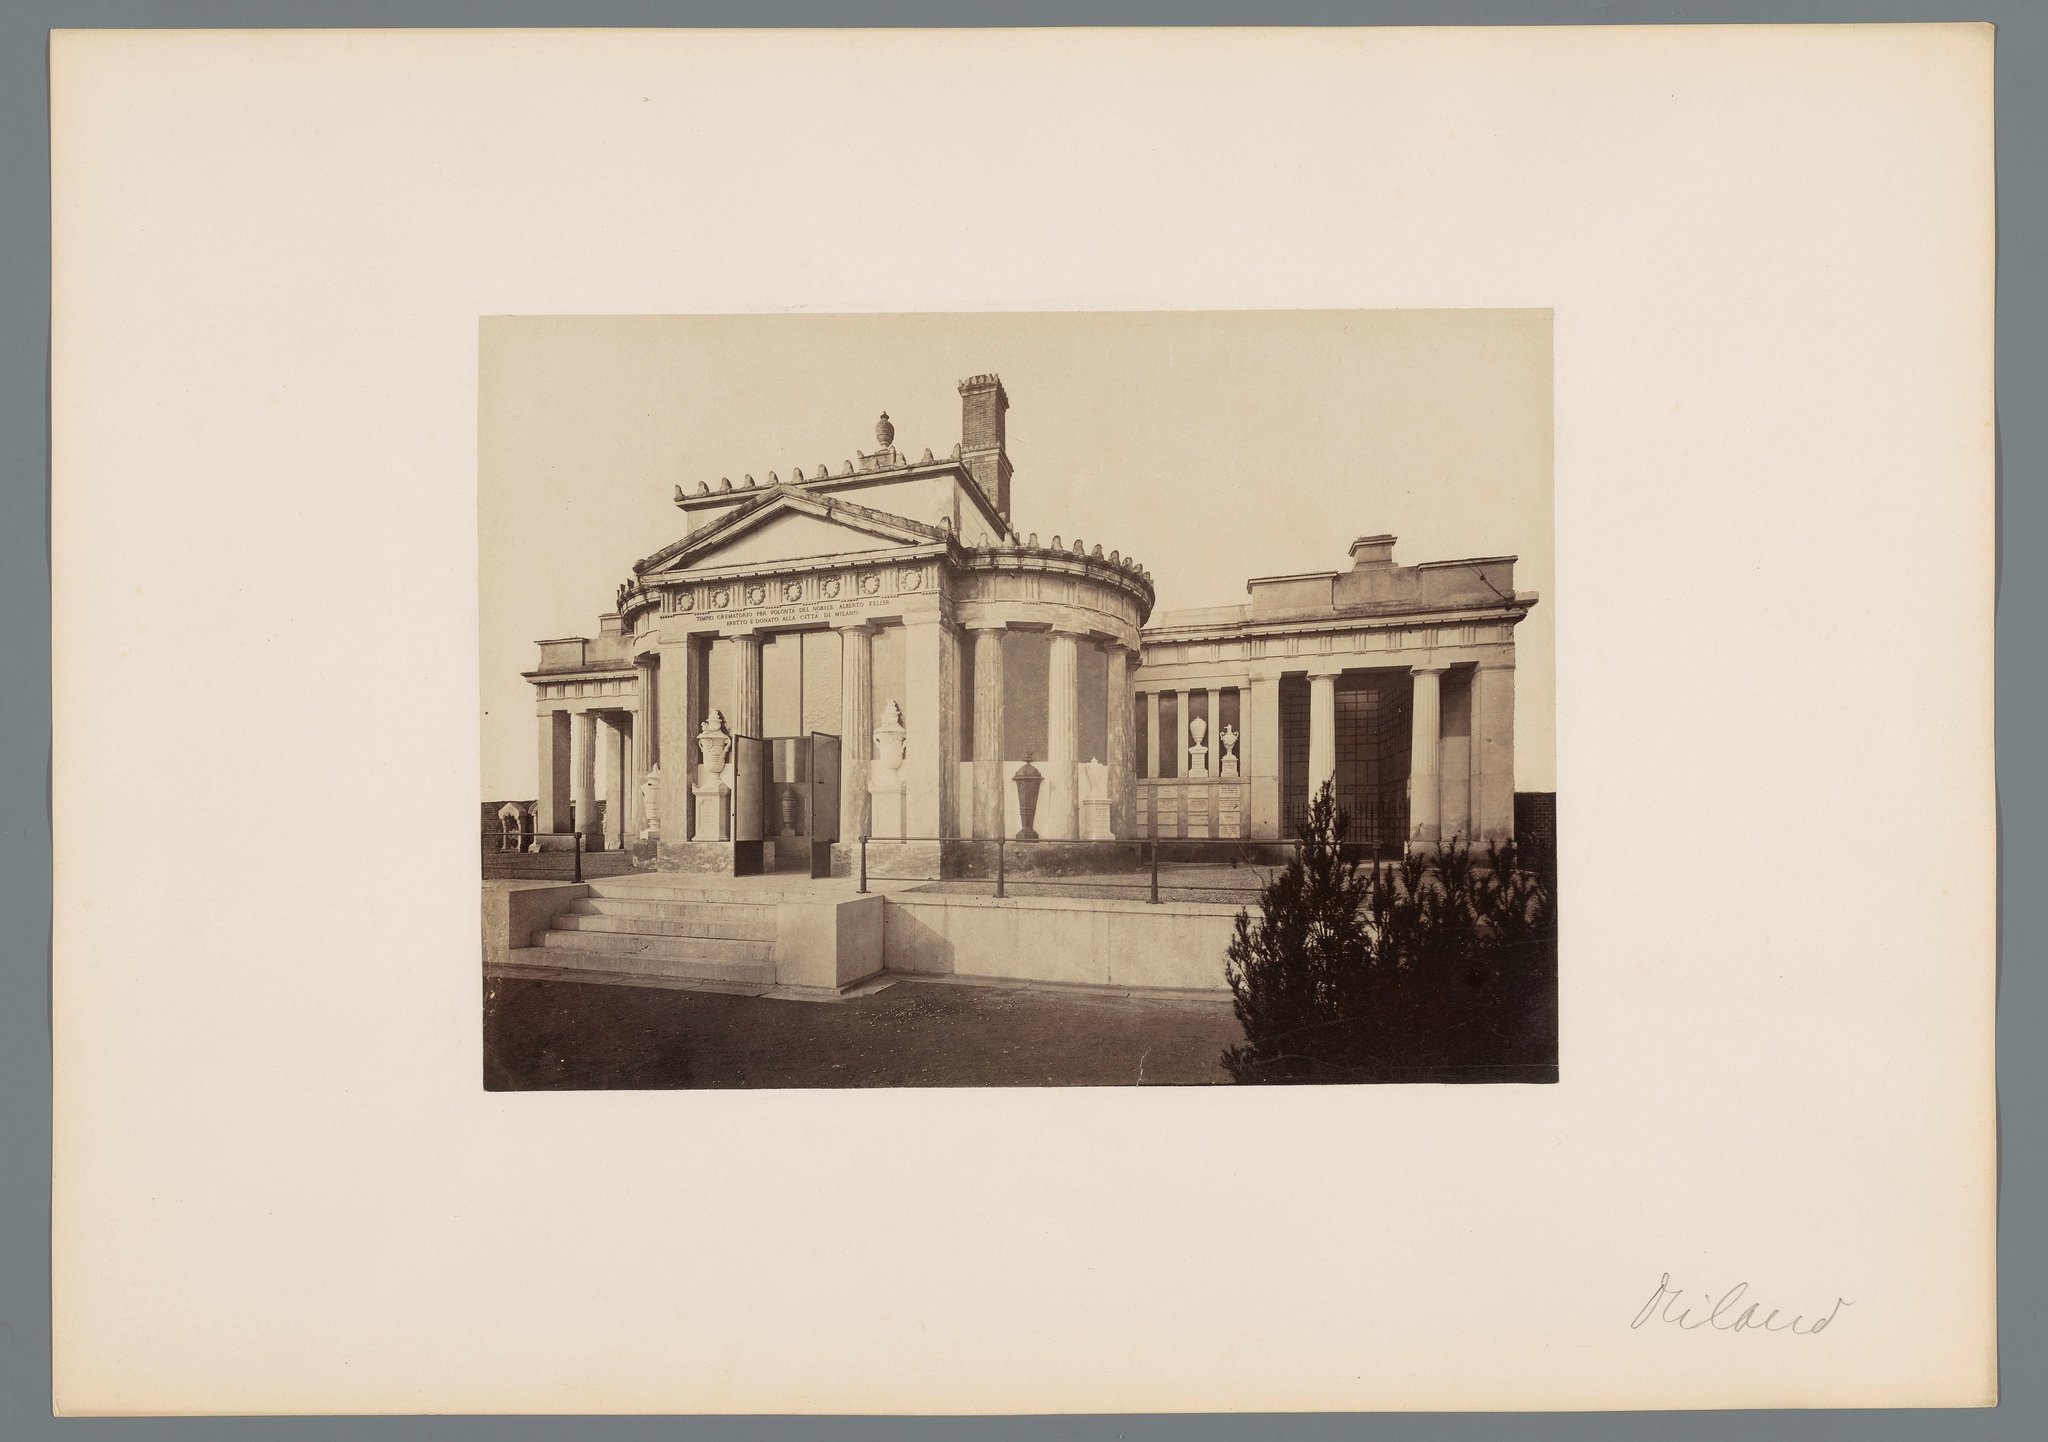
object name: photograph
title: Tempel op het Cimitero Monumentale te Milaan, Italië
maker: Anonymous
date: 1851-1900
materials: cardboard, paper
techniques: albumen print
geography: milan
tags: churchyard, cemetery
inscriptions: inscription: ‘Milano’